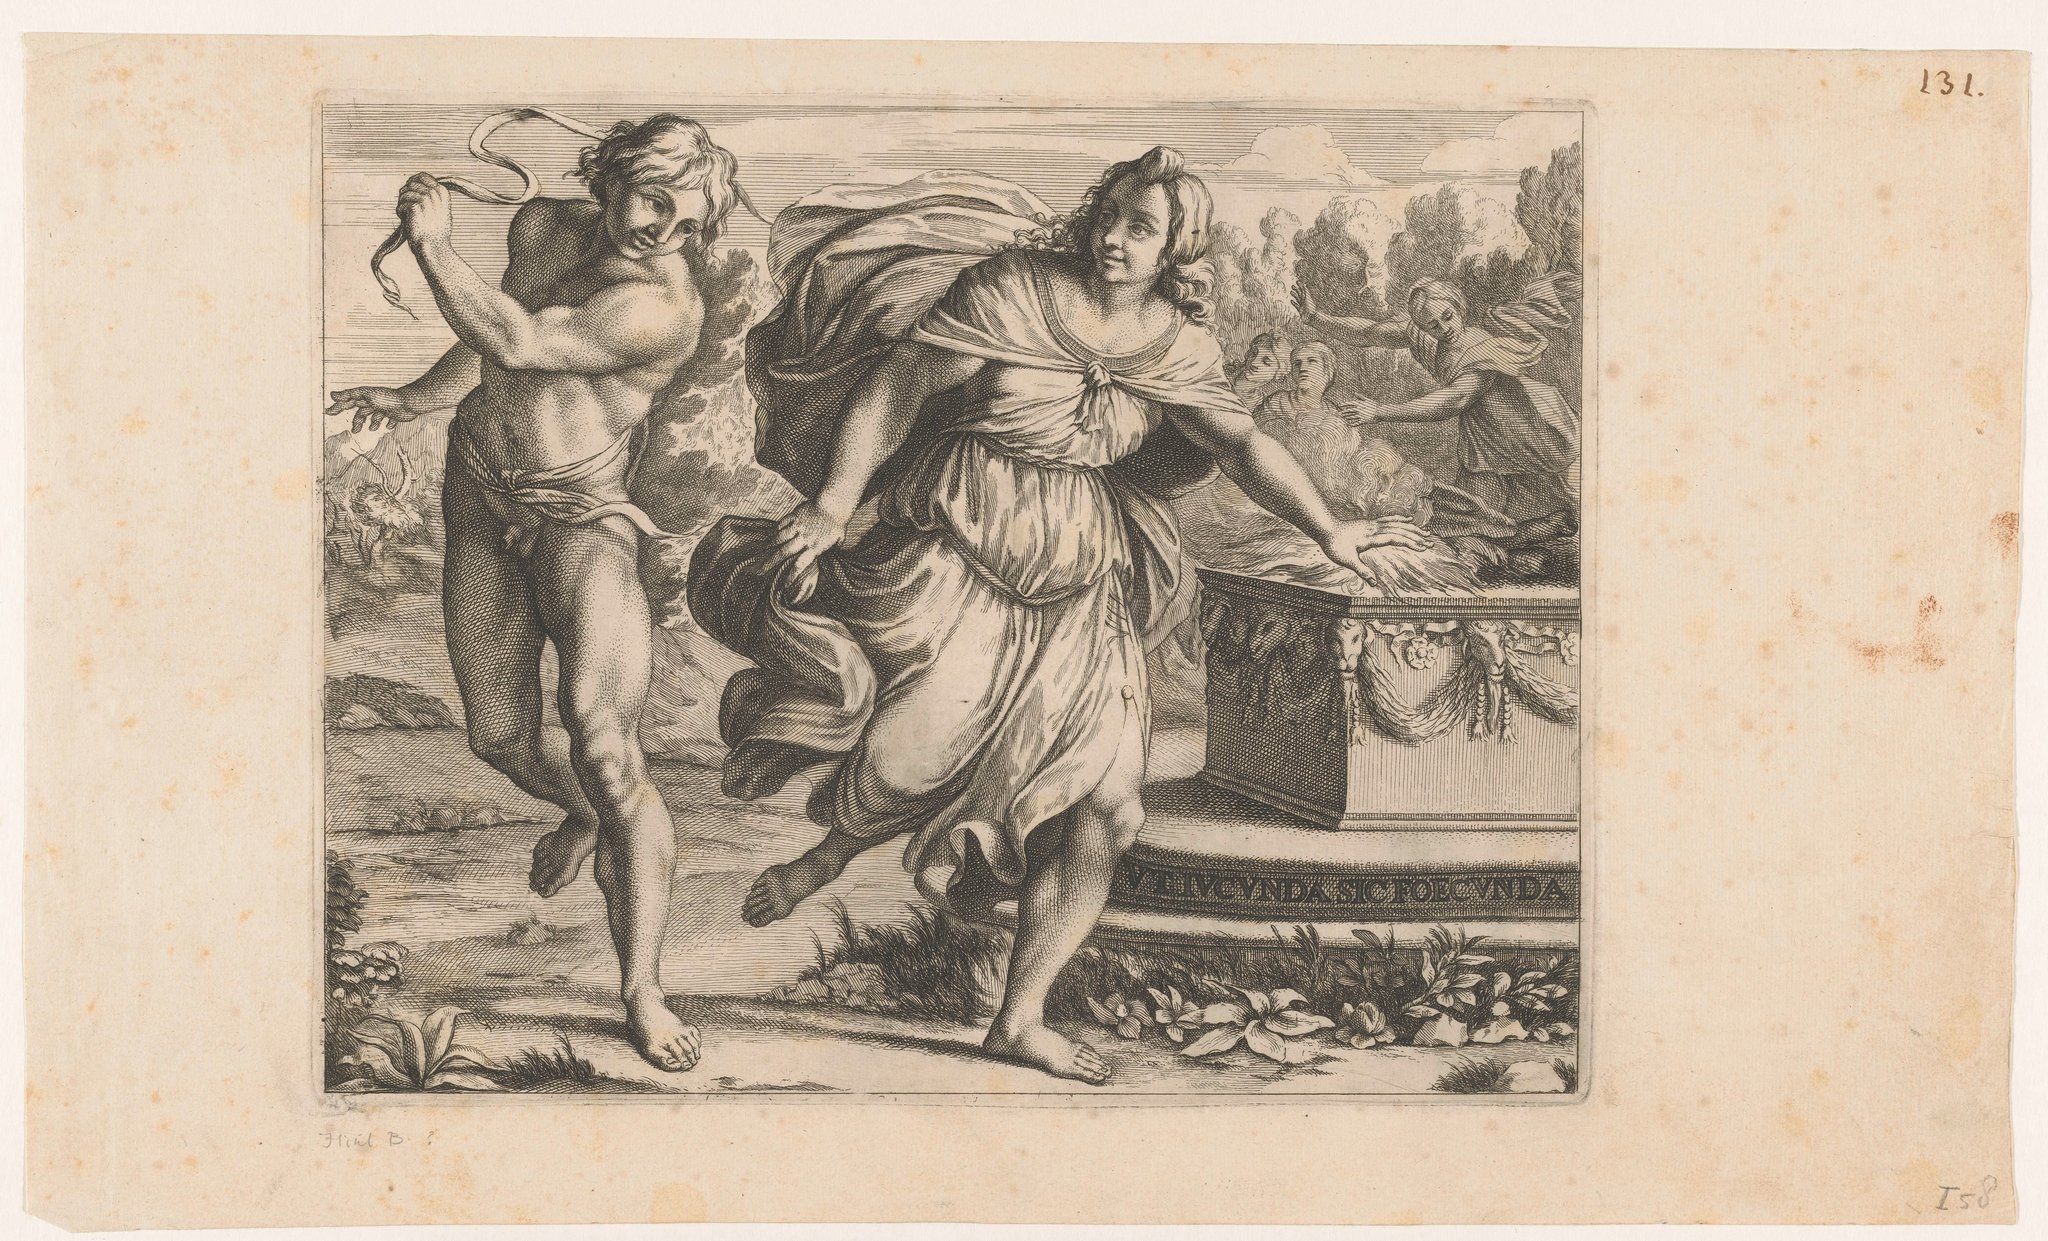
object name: print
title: Lupercalia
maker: Anonymous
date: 1677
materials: paper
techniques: engraving, etching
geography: rome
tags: 'lupercalia', feast in honour of faunus-lupercus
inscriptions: collector's mark: Lugt 11, collector's mark: ‘Hinloopen’, number: ‘131’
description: Naar een schildering door Annibale Carracci in Palazzo Magnani te Bologna. Deze prent maakte oorspronkelijk deel uit van liber nr. 22 van de Atlas van Rome, uit de collectie Hinloopen. In dit album waren een aantal prentreeksen naar bekende zeventiende eeuwse frescoseries bijeengebonden. In 1709 heeft Schijnvoet op last van de burgemeesters van Amsterdam de collectie herordend. De prenten uit liber 22 kwamen terrecht in Schijnvoet boek nr. 10. De laatst gedateerde reeks in het album is gedateerd 1691. Het album moet dus na deze datum gebonden zijn. De band is in de Rijksakademietijd uit elkaar gehaald. De marges van de prenten zijn bij het opbergen in het Rijksprentenkabinet vaak drastisch afgesneden. Van een aantal series waren de prenten teruggeslagen om in het album te passen. (Zie: Waals, Jan van der. De prentschat van Michiel Hinloopen. 's-Gravenhage: SDU uitgeverij, 1988, pp. 173-174.)